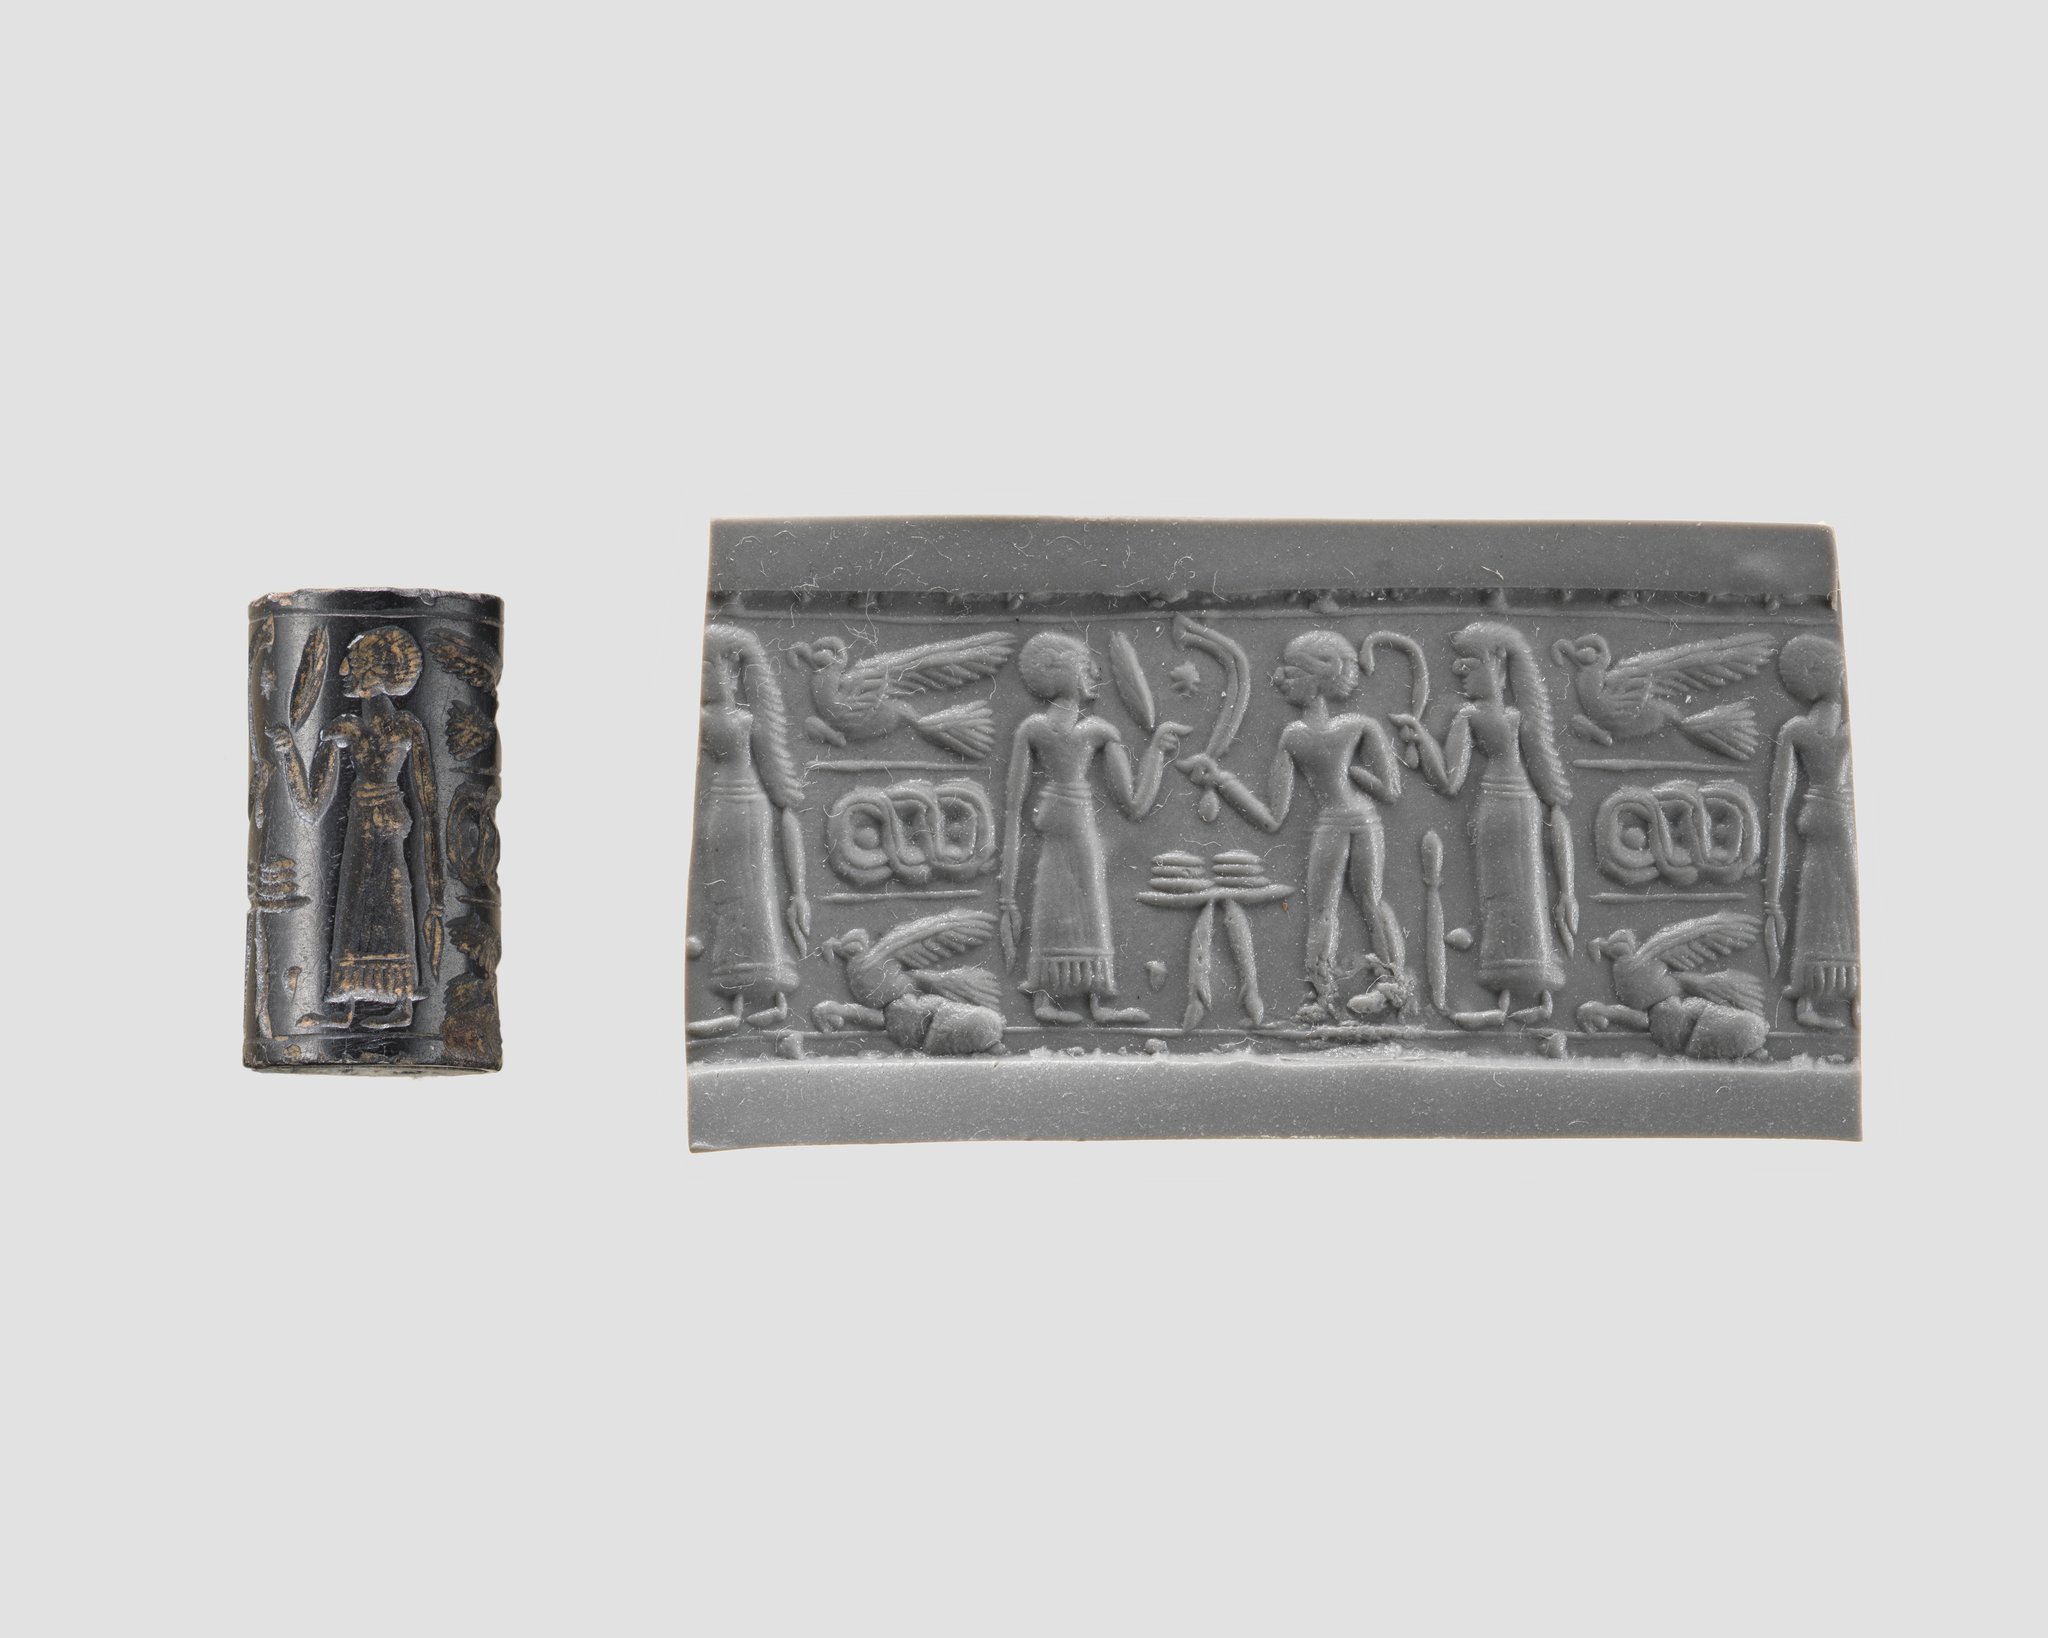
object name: cylinder seal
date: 1820-1730 BCE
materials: mineral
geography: syria